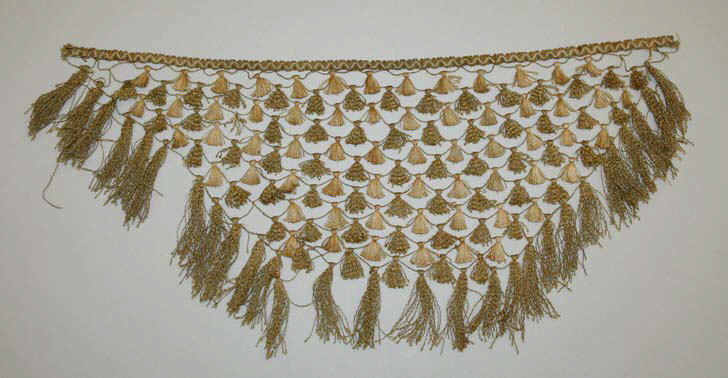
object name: headdress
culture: american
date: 1840-1850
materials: silk